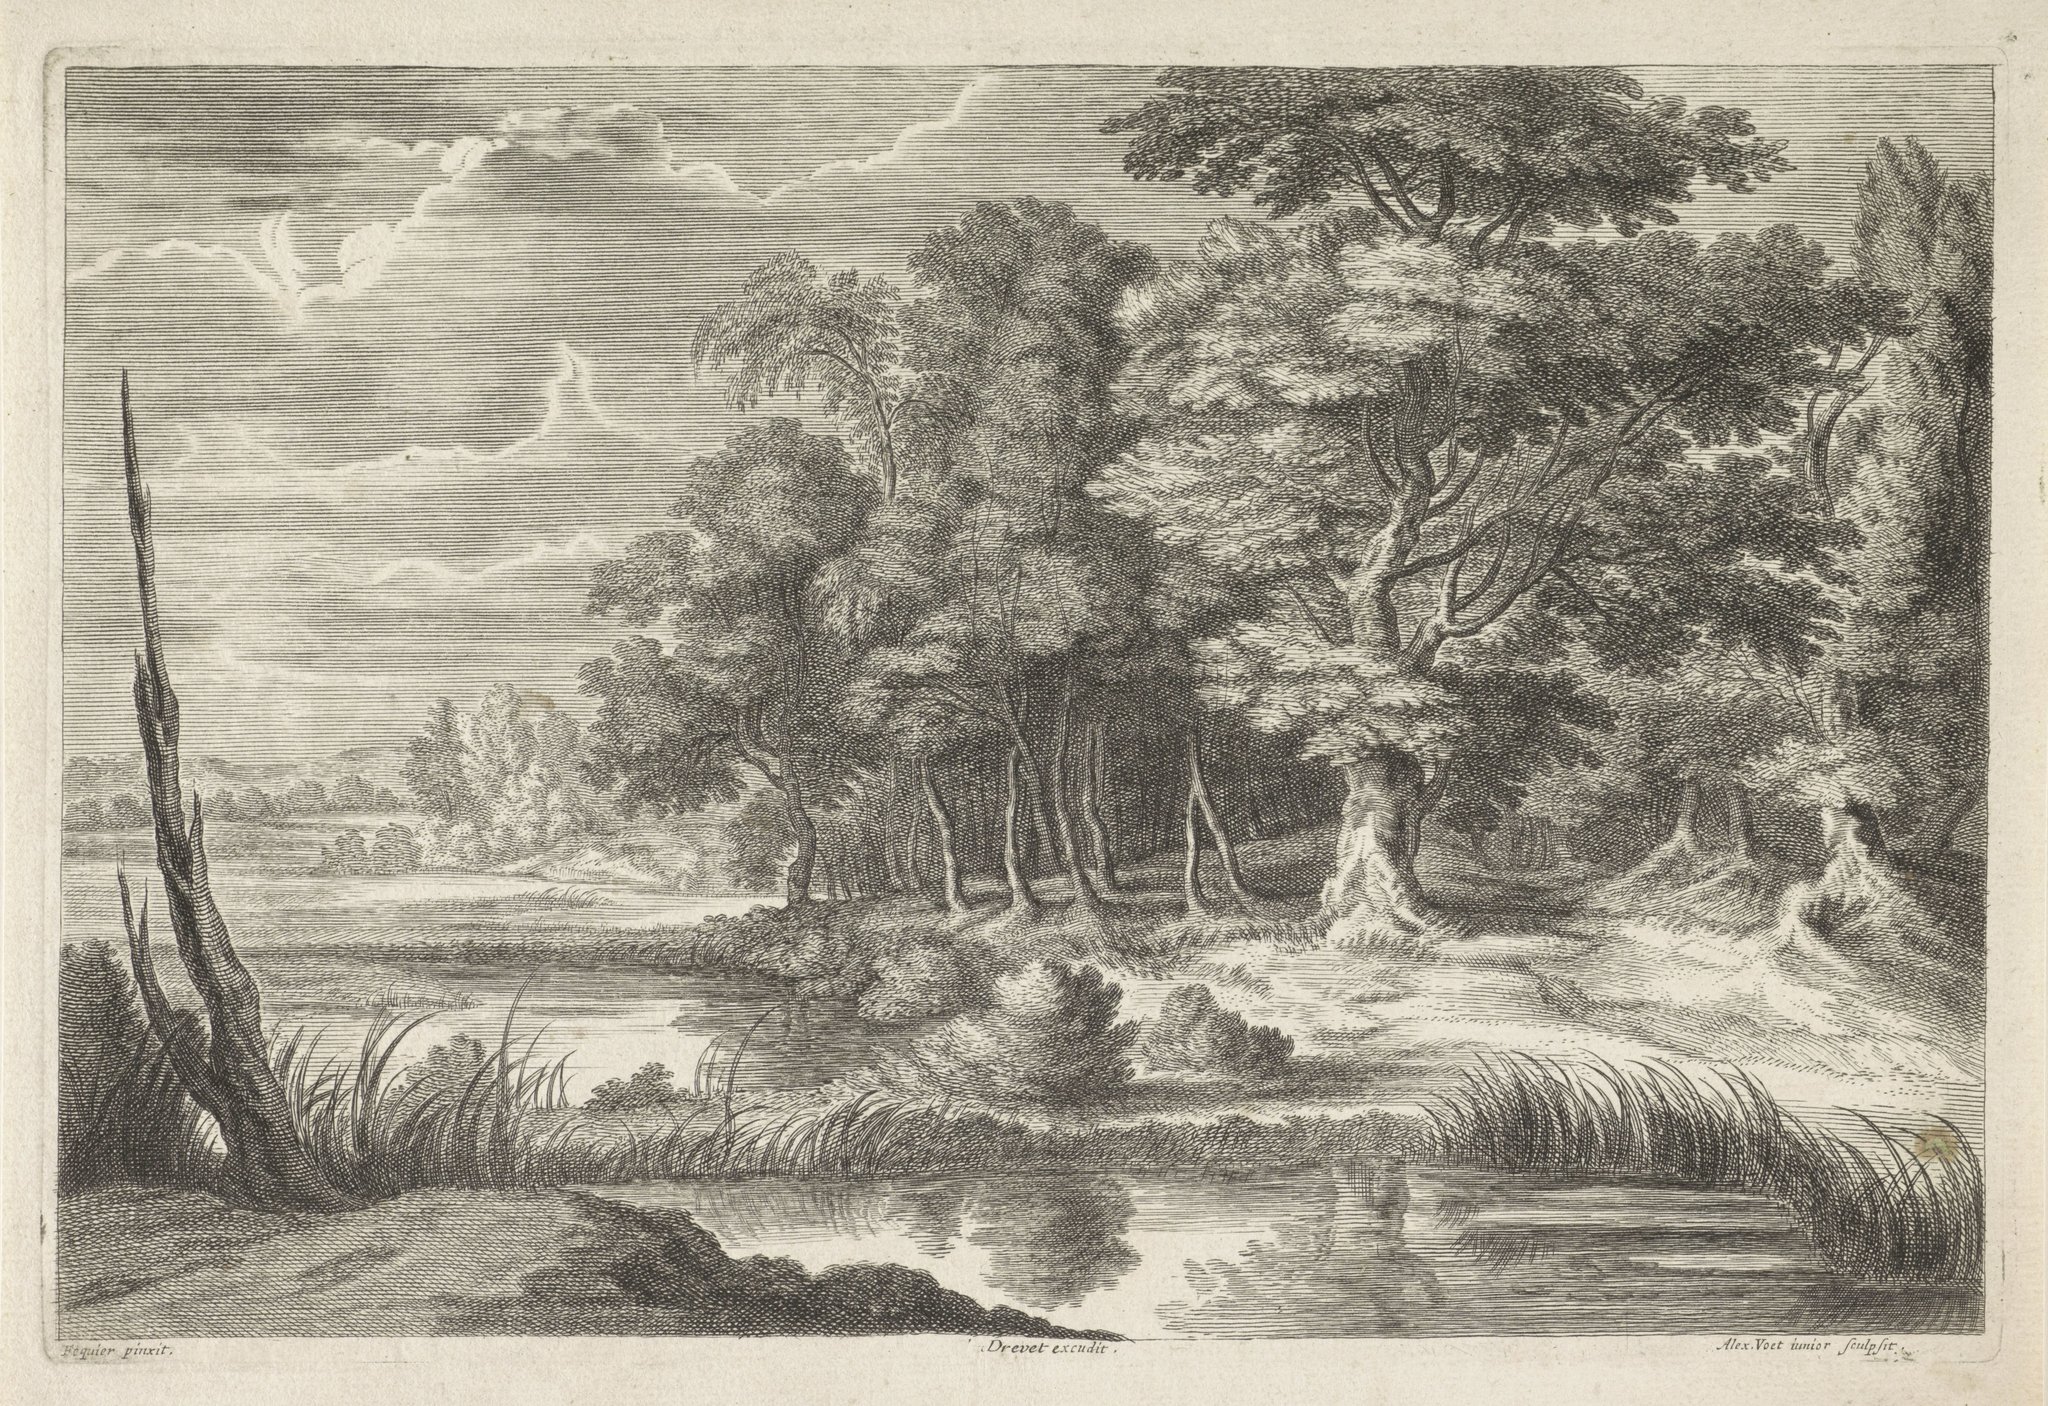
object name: print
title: Landschappen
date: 1673-1738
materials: paper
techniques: engraving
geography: france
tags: forest, wood, pond, pool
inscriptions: collector's mark: Lugt 2228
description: Landschap met ter zijde een kale boomstam aan de oever van een bosvijver.